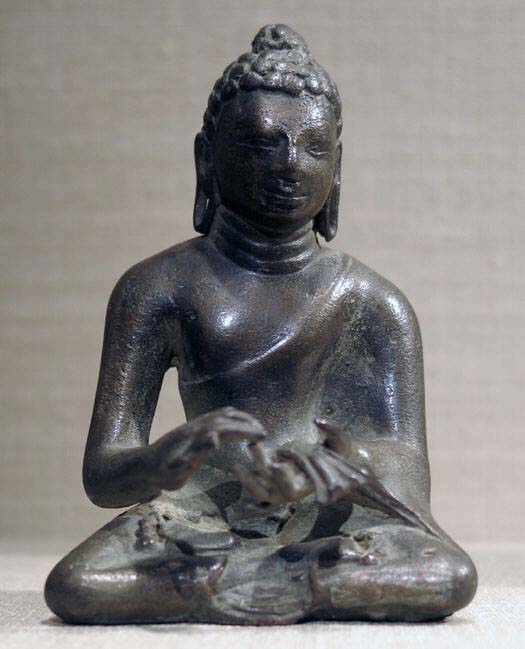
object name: figure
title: Seated Buddha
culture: burmese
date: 601-800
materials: bronze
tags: buddhism,buddha